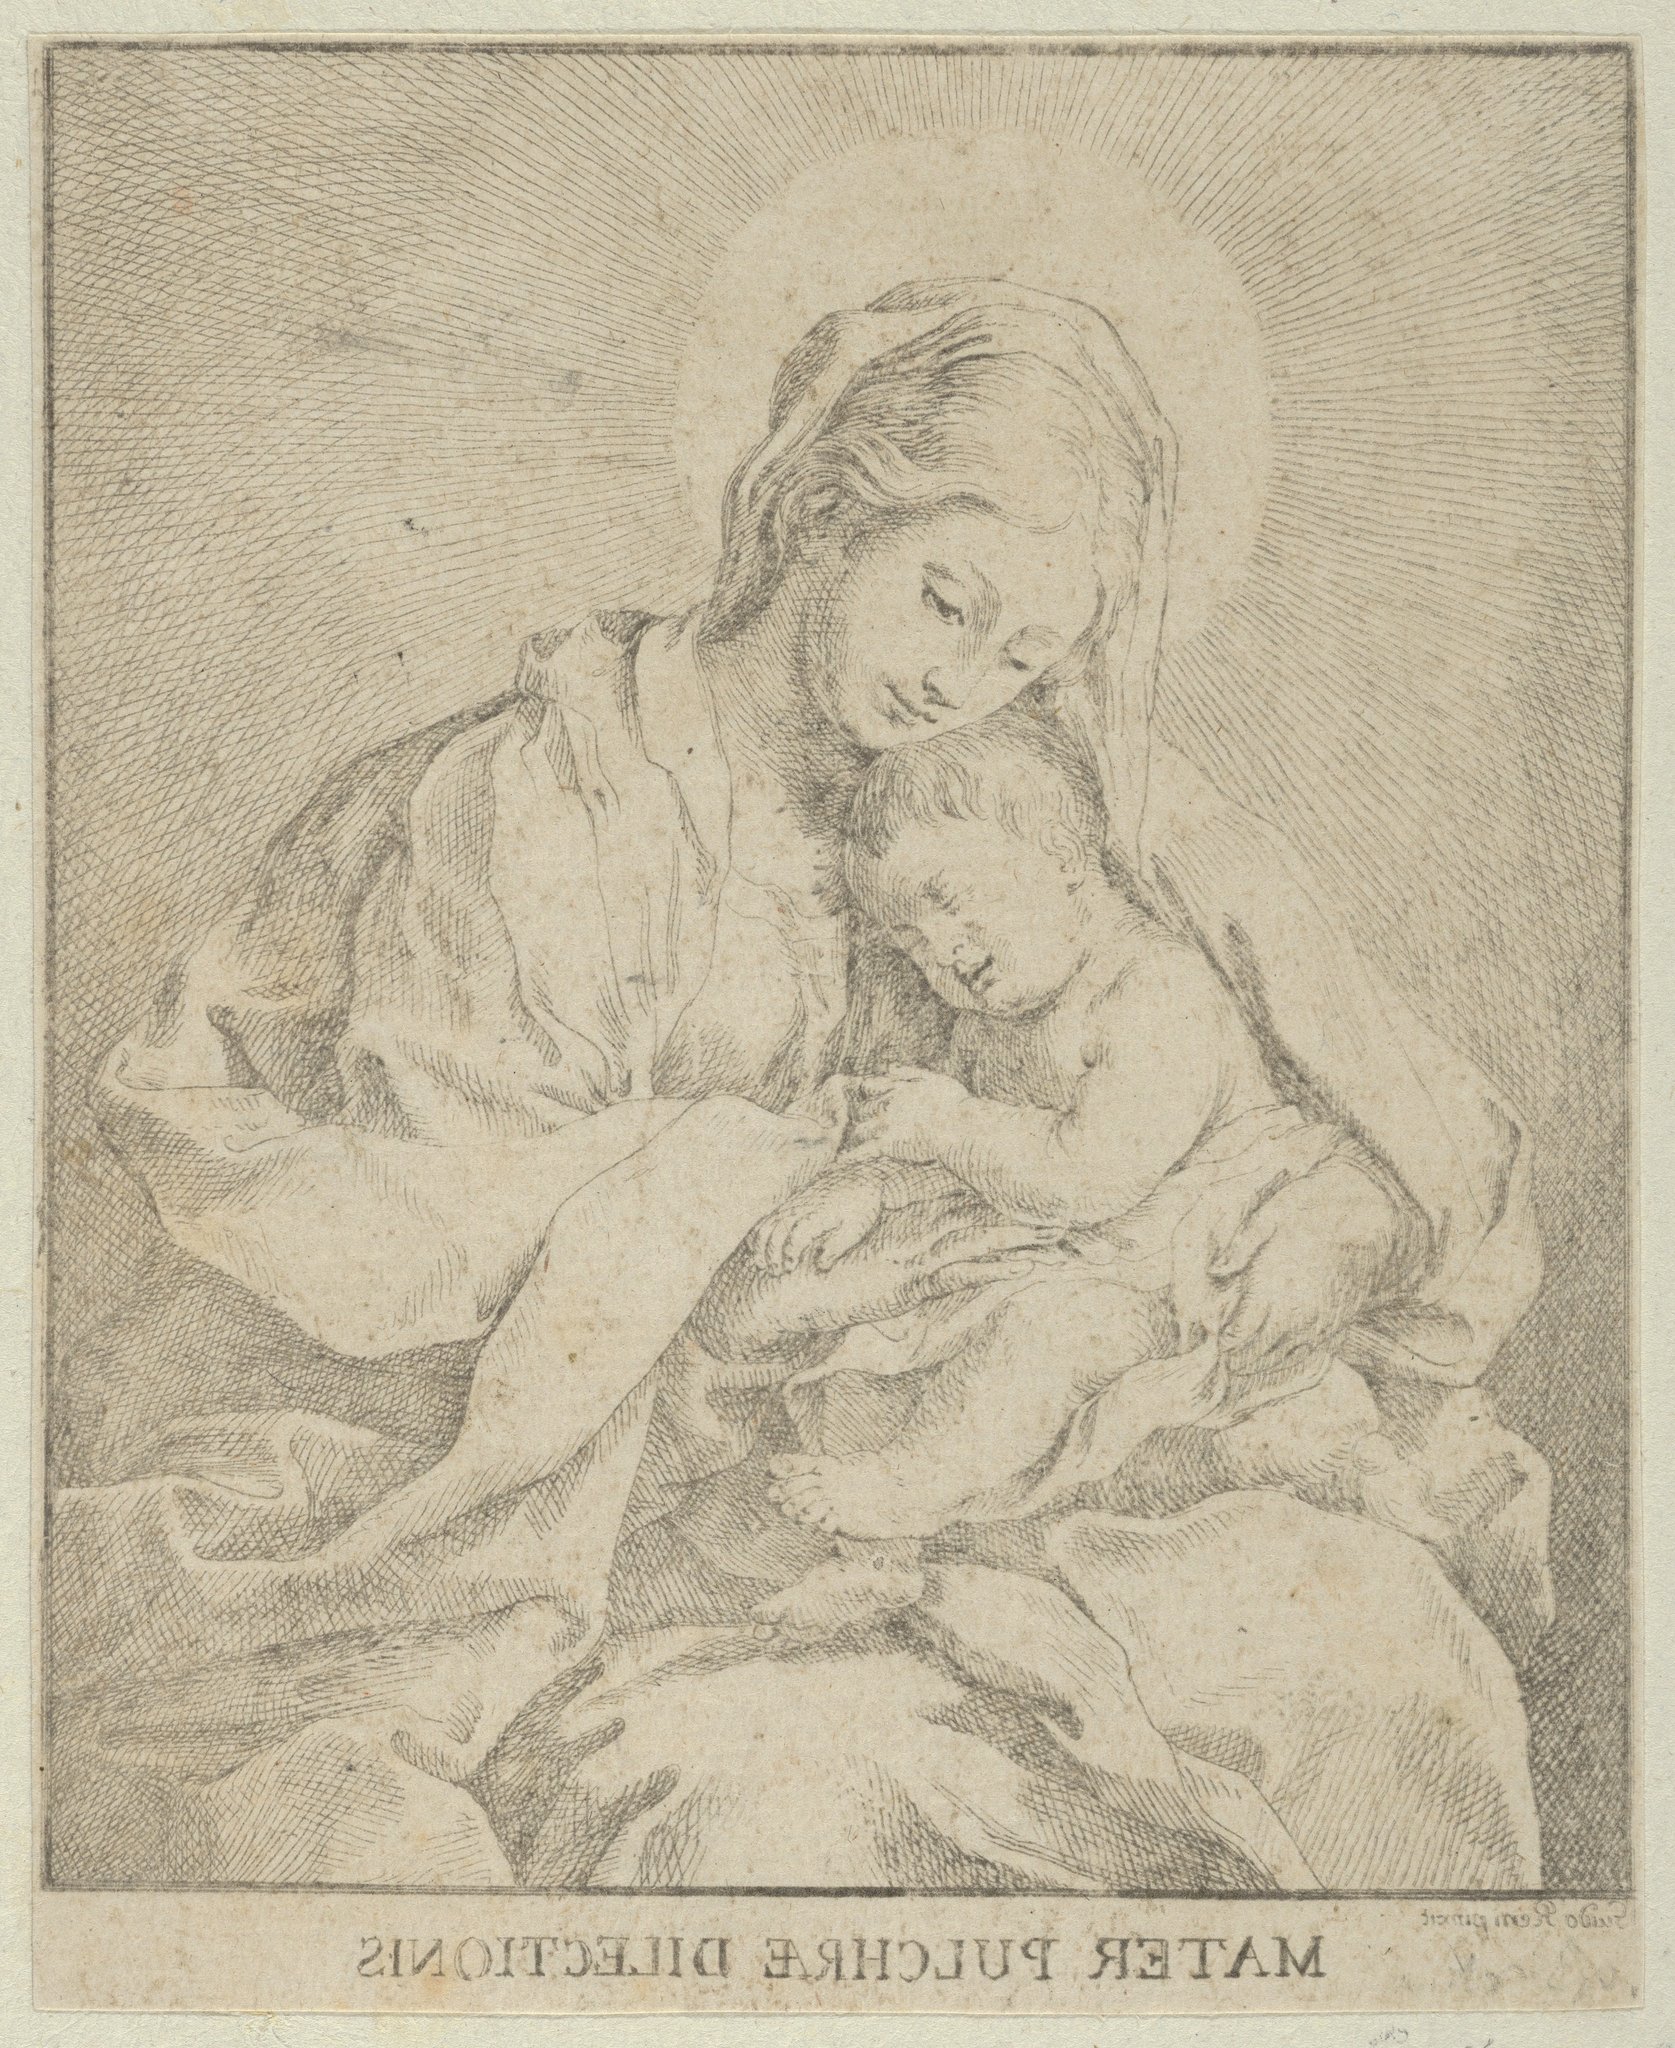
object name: print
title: The Virgin holding the infant Christ, after Reni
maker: johann christoph winkler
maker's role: artist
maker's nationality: german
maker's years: 1701-1775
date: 1720-1770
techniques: printmaking, etching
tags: madonna and child